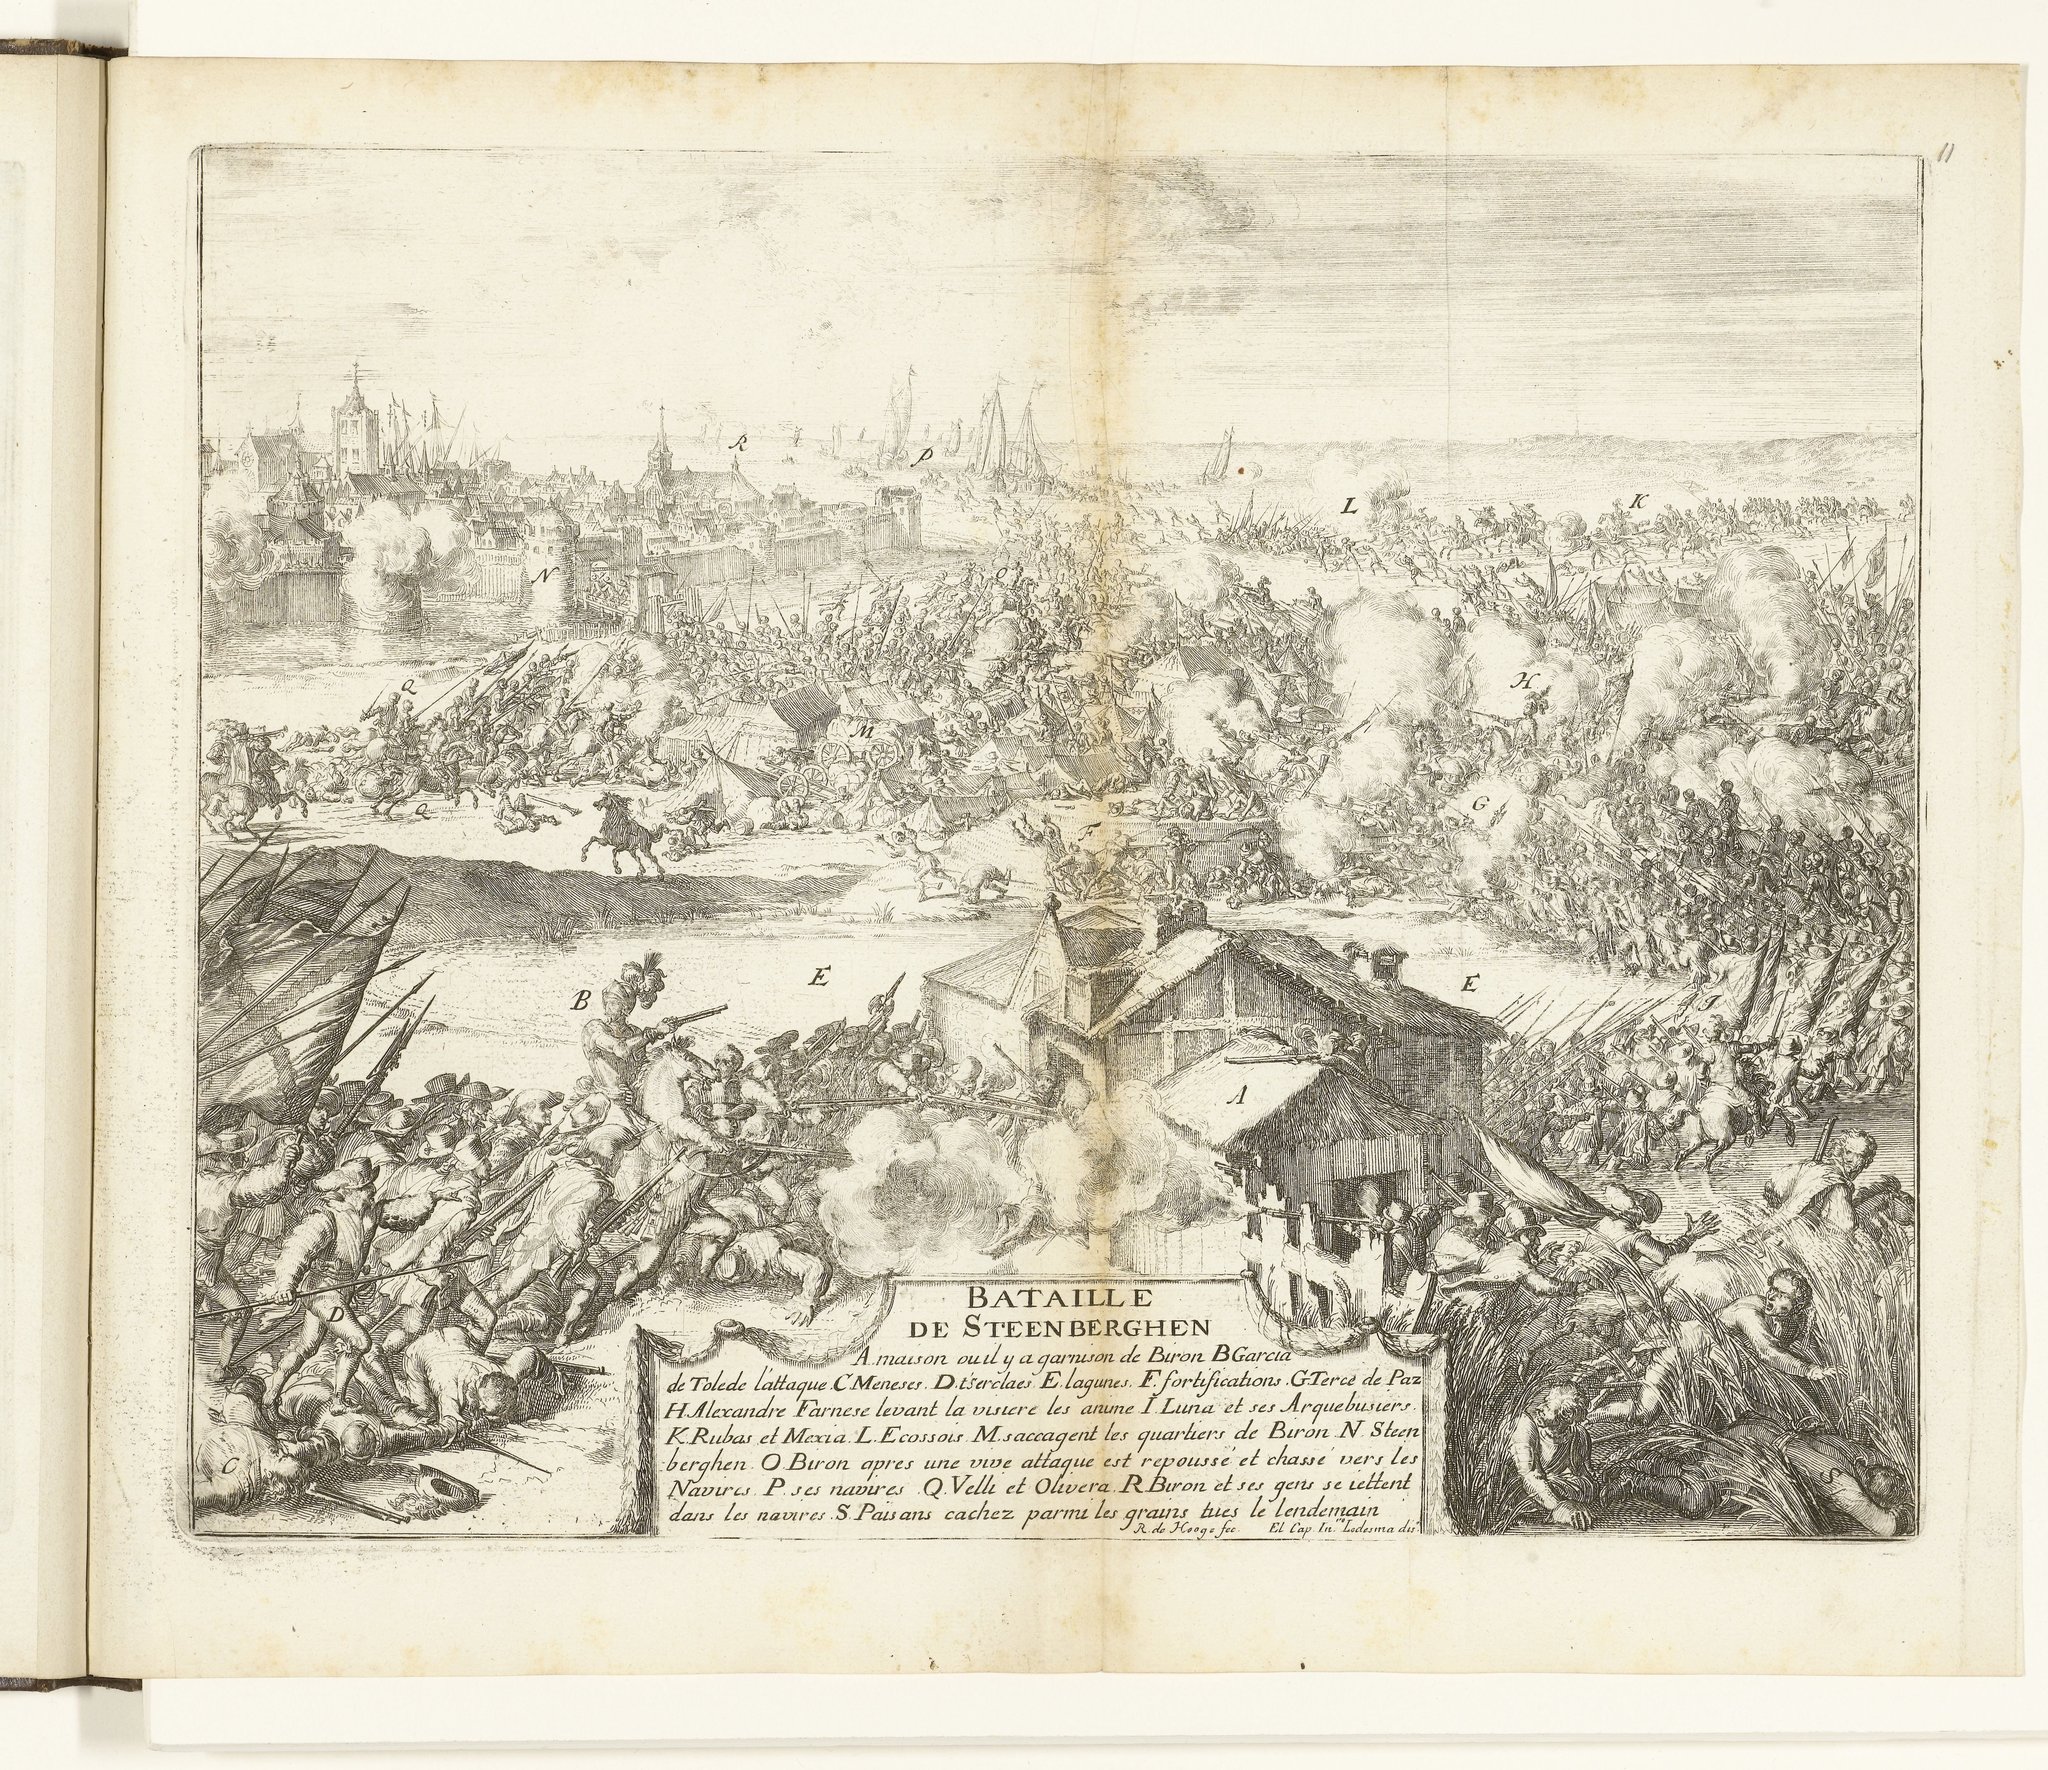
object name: print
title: Slag bij Steenbergen, 1583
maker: romeyn de hooghe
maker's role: draughtsman, goldsmith, painter, print maker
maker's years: 1645-1708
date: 1670-1699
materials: paper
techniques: etching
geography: netherlands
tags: battle, fighting in general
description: Waarschijnlijk oorspronkelijk vervaardigd voor een uitgave van Histoire de la guerre de Flandre, van F. Strada, eind 17e eeuw. De prent is onderdeel van een bundel van prenten en portretten getiteld Des Guerres de Flandres, in drie delen, met in totaal 22 batailles, 6 portretten en 3 titelprenten voor de afzonderlijke delen, alles (behalve de portretten) door De Hooghe en Ledesma in één band, ongenummerd en zonder titelblad (zie Rijksmuseum Research Library, inv.nr. BI-1929-10, 329 C 20). De prenten hebben betrekking op de periode 1567-1592.